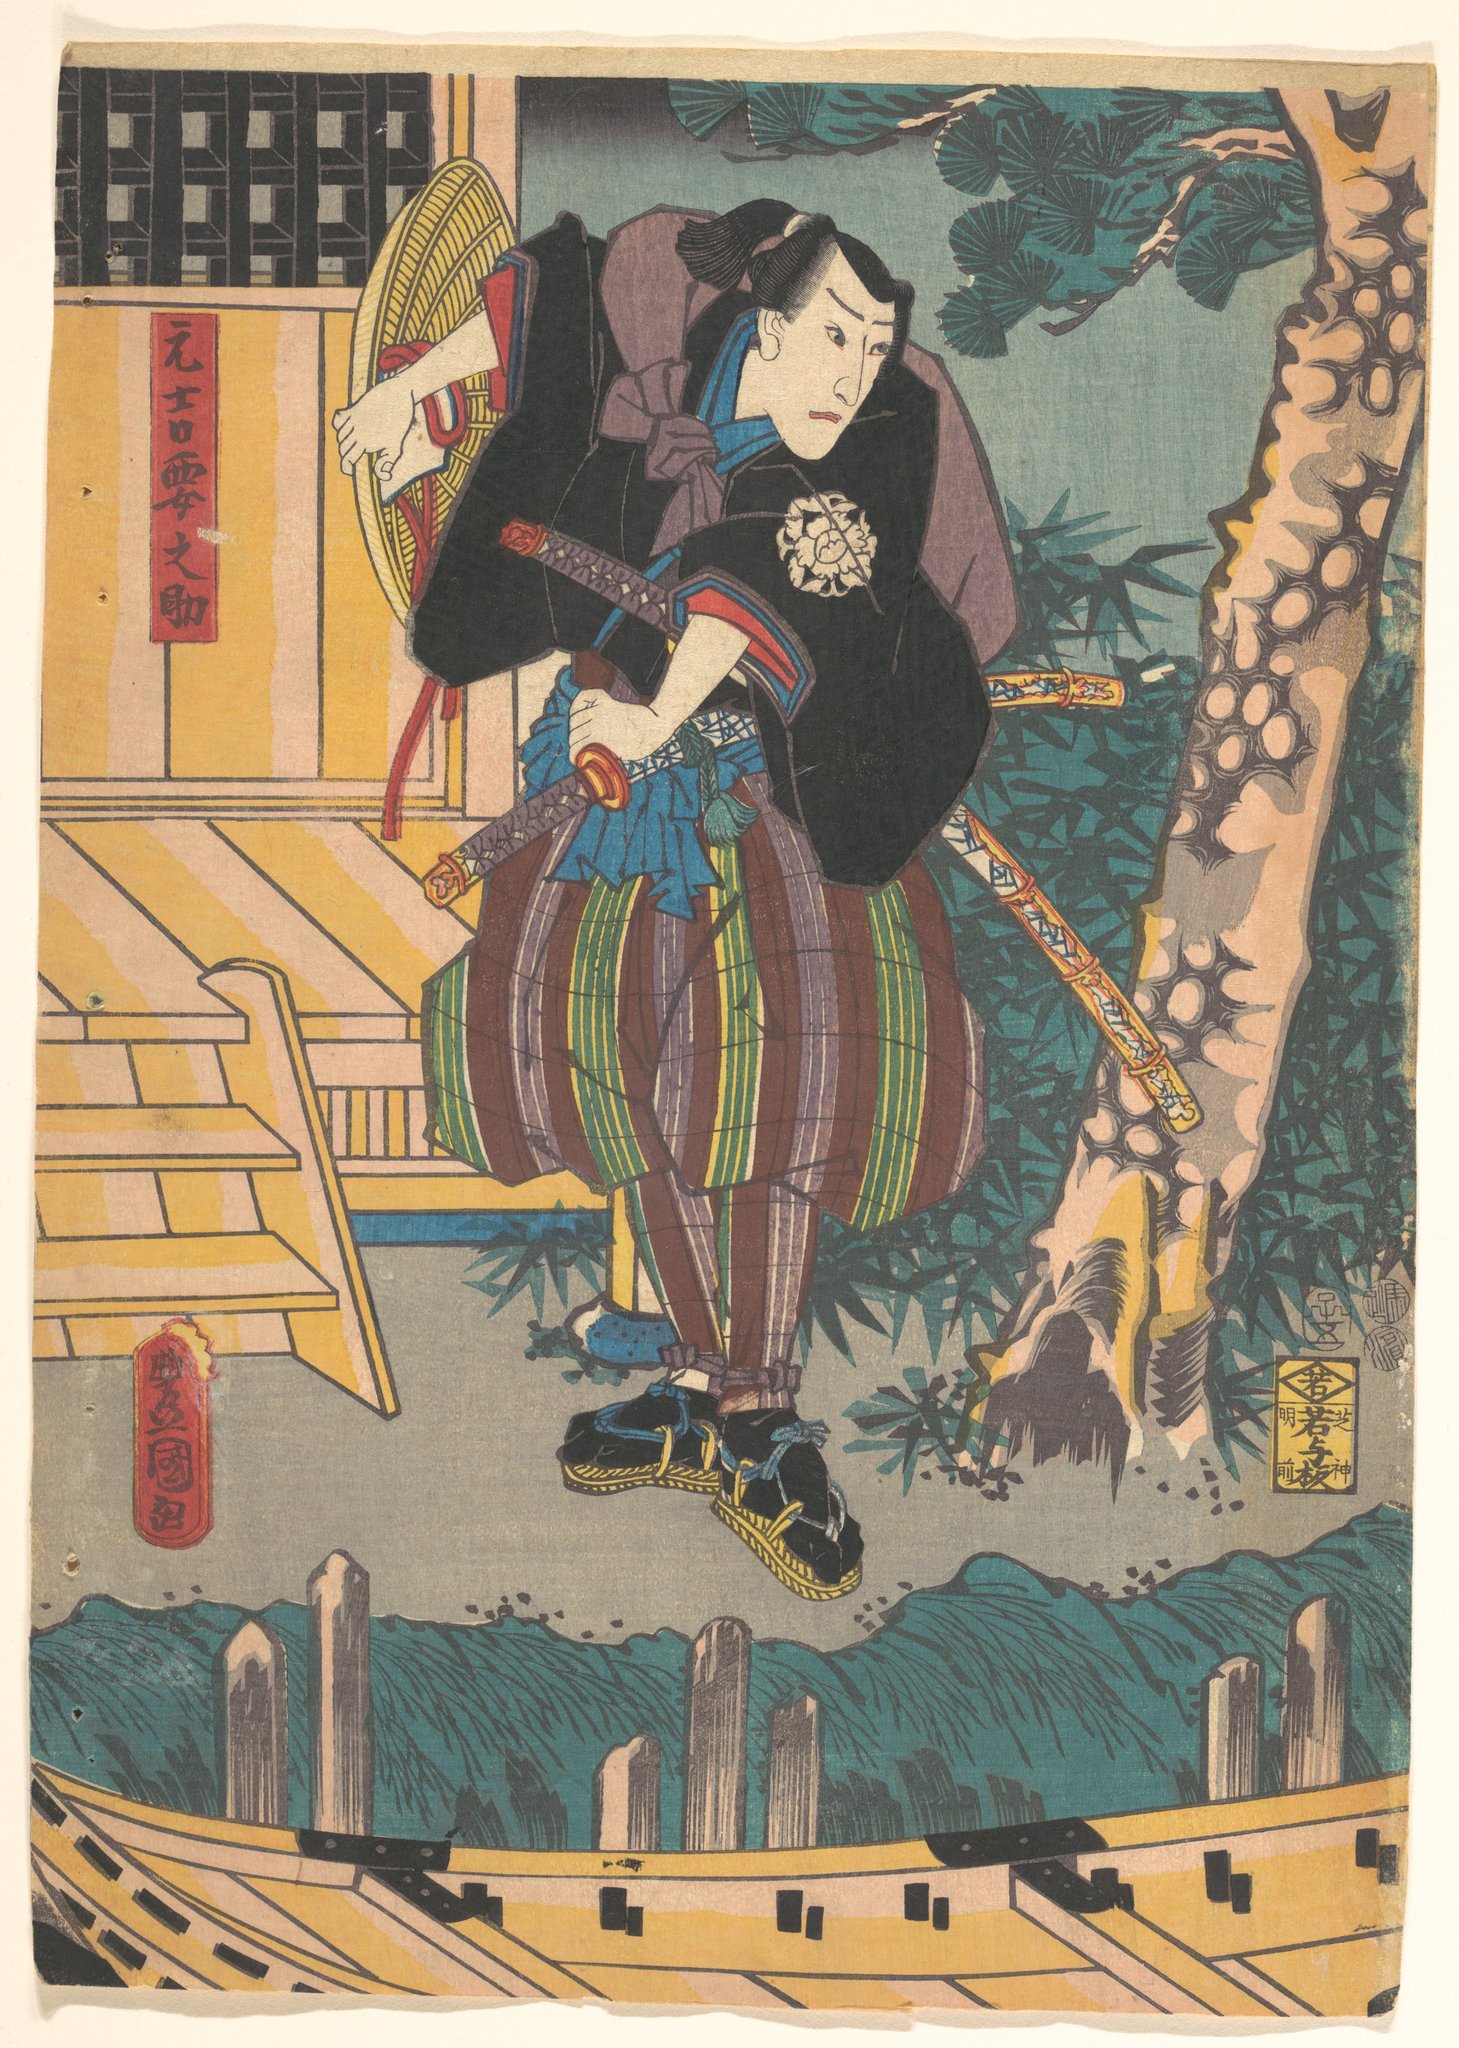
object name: print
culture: japanese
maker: utagawa kunisada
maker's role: artist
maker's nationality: japanese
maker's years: 1786-1864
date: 1801-1900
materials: ink, paper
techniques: woodblock print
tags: weapons,men,trees